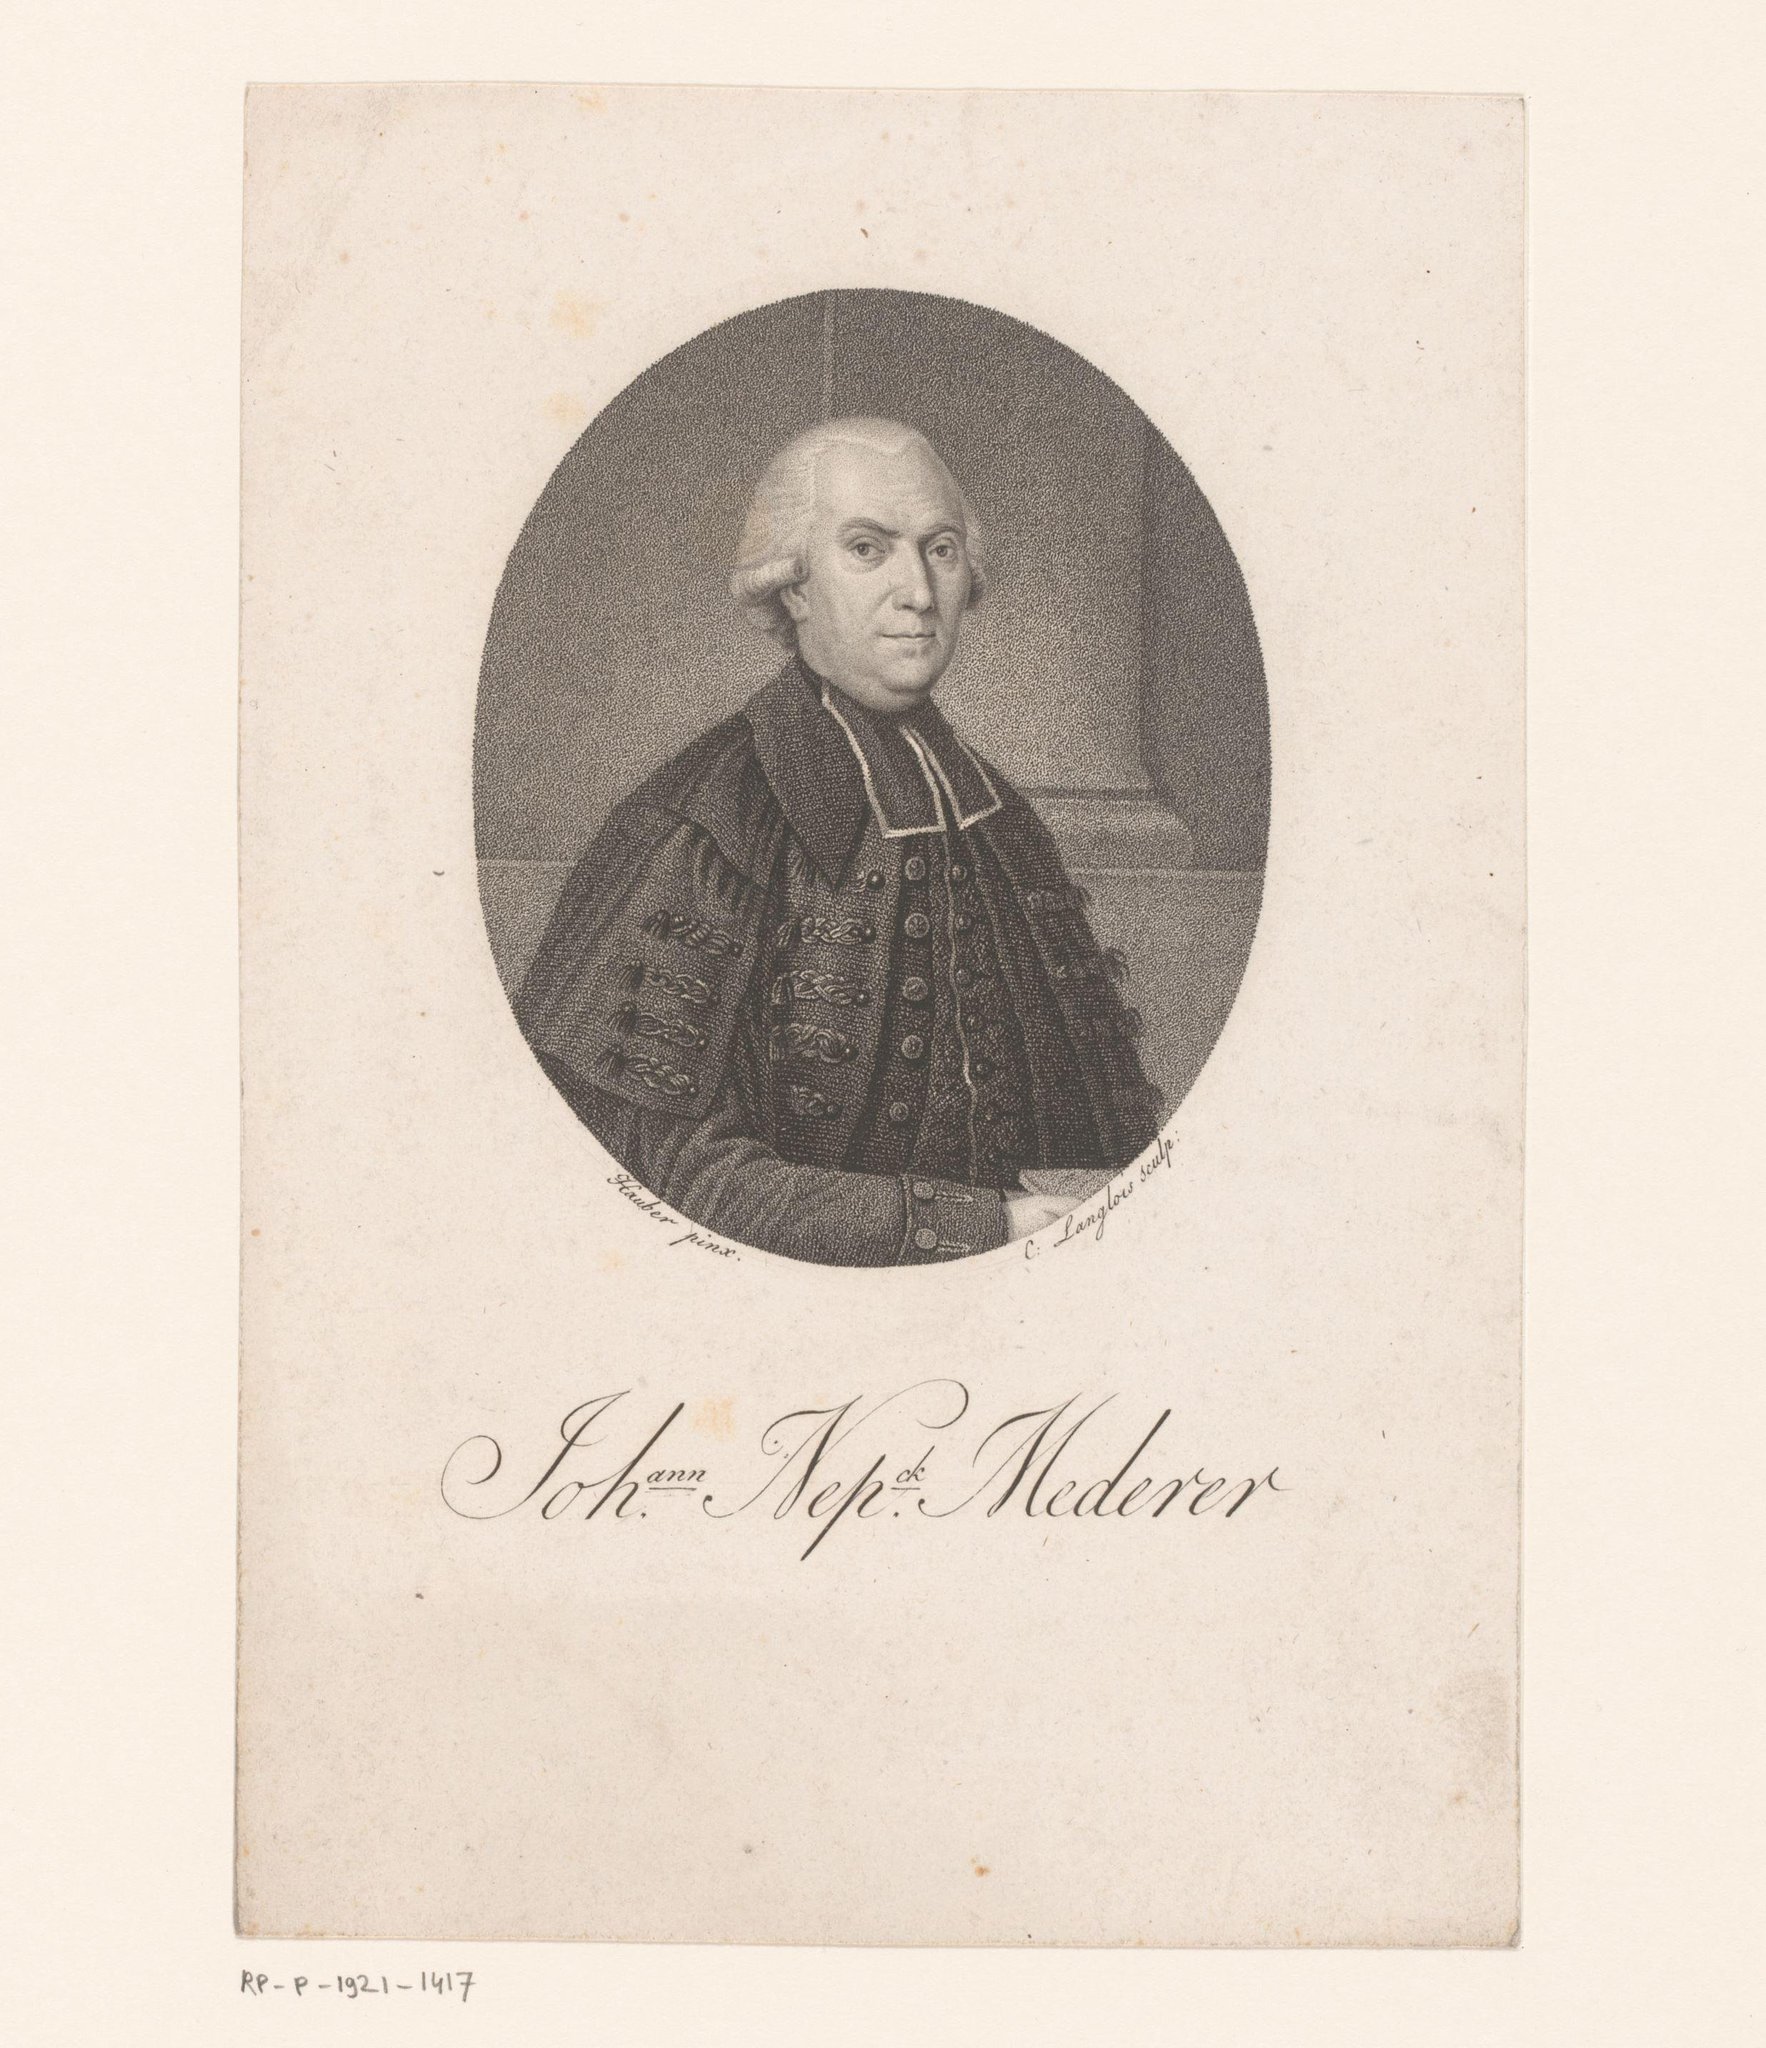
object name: print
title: Portret van Johann Nepomuk Mederer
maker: jean charles langlois (colonel)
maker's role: painter, print maker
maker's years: 1789-1870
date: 1799-1870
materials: paper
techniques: engraving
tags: historical persons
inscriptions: collector's mark: Lugt 2233